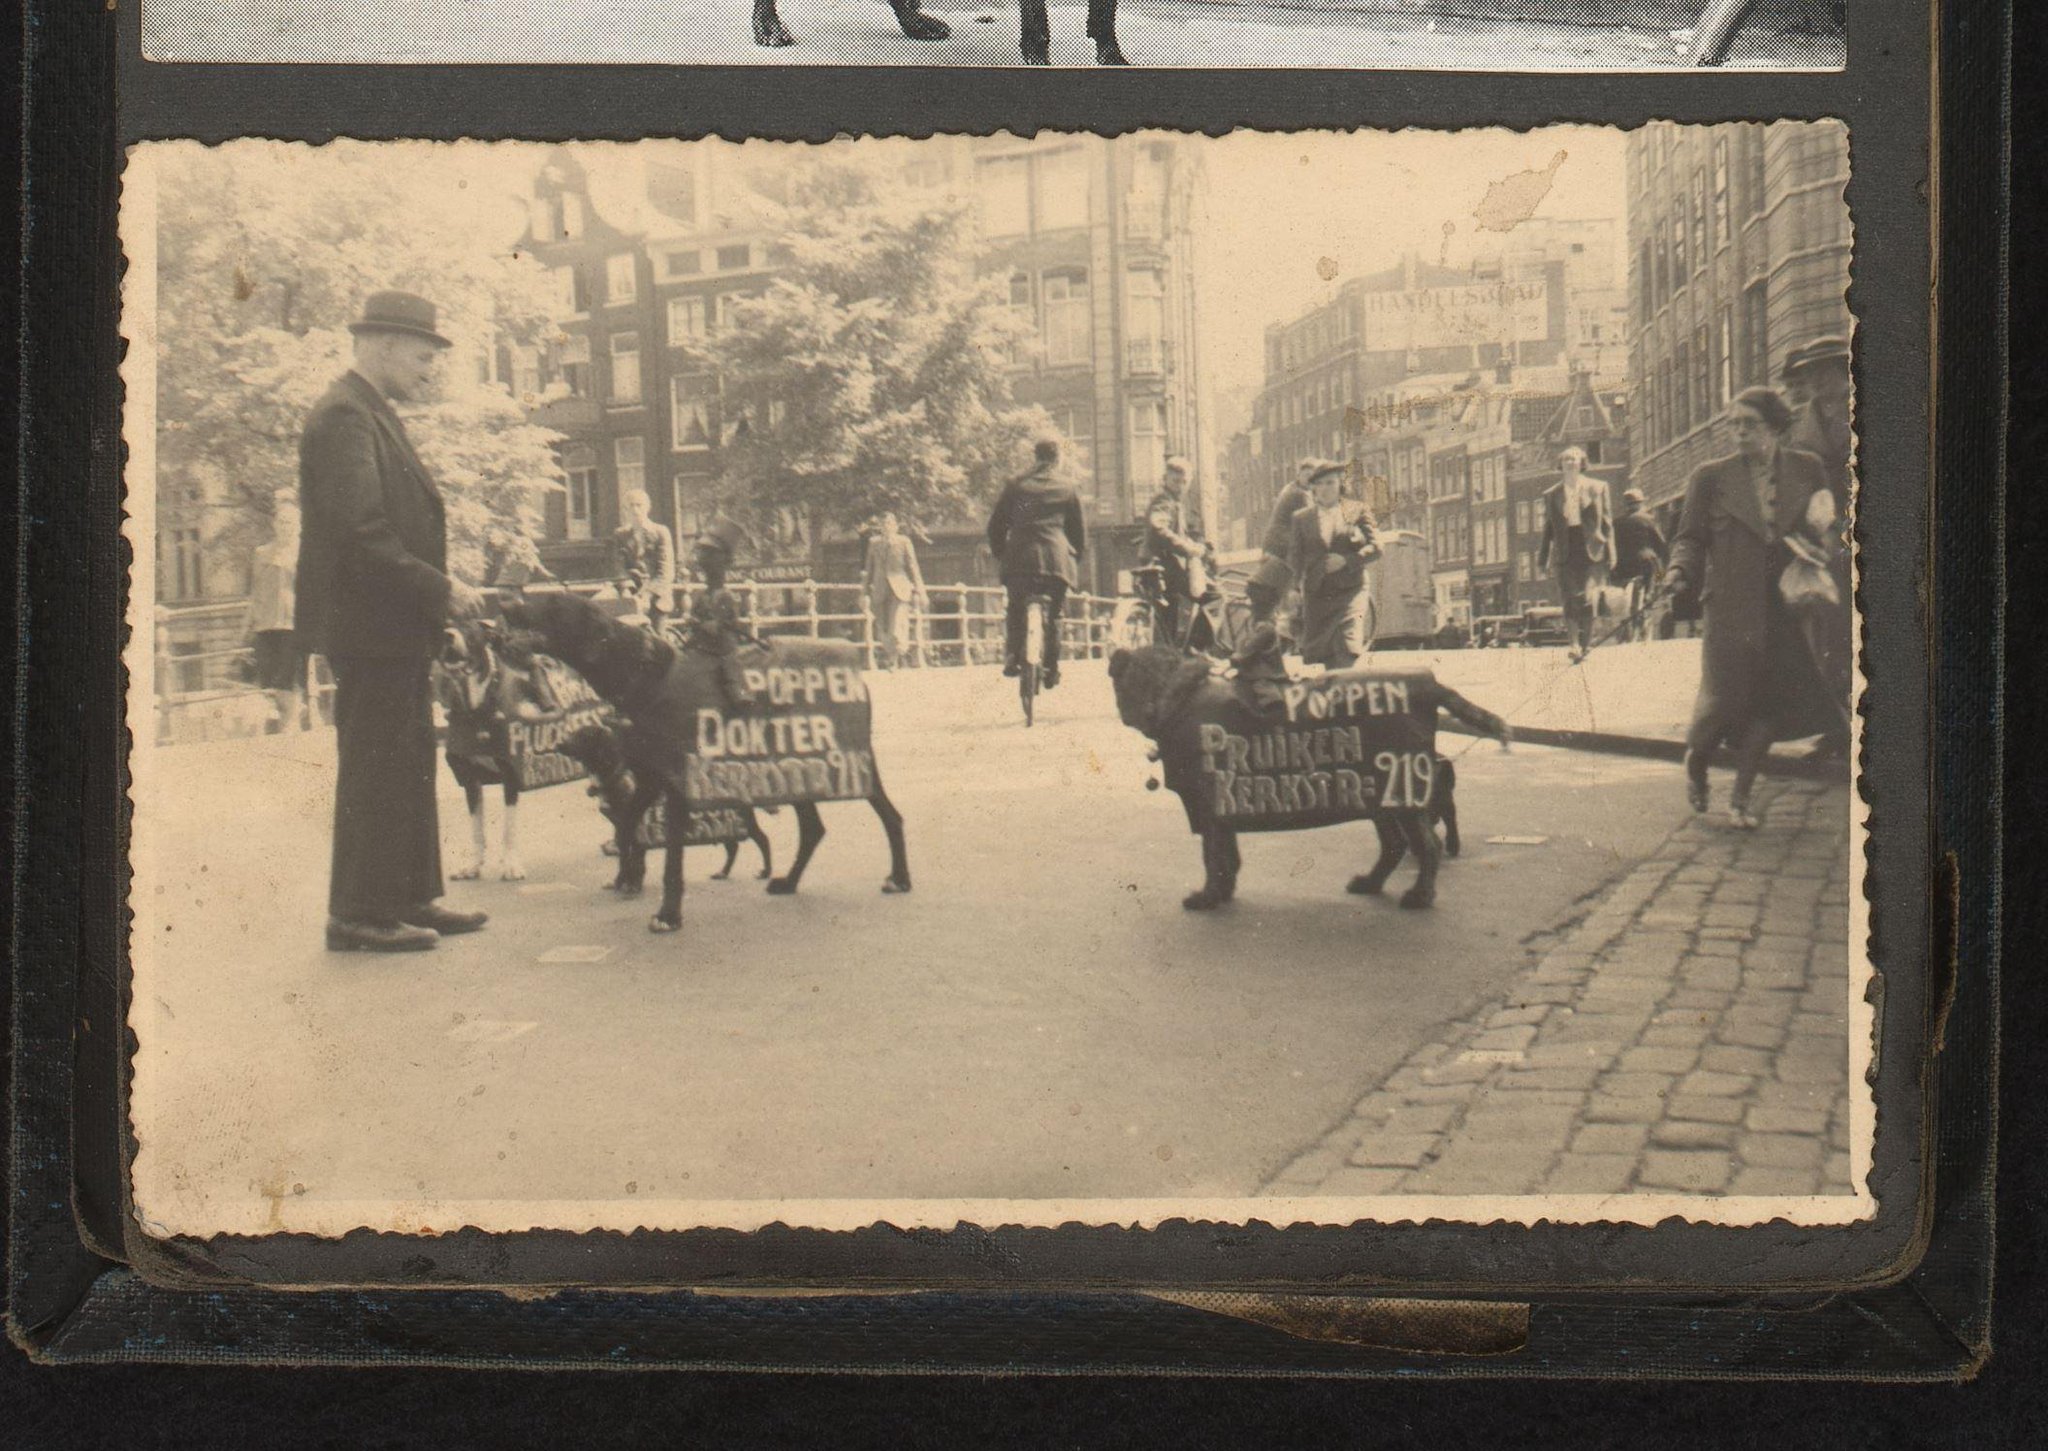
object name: album leaf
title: Reclamehonden van de poppendokter op straat in Amsterdam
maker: Anonymous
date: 1930-1940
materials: photographic support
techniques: gelatin silver print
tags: advertising, historical persons, street, dog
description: Reclamehonden van de poppendokter op de hoek Singel-Gasthuismolensteeg in Amsterdam. Rechts over de brug het Bungehuis. Deze foto maakt deel uit van een album.